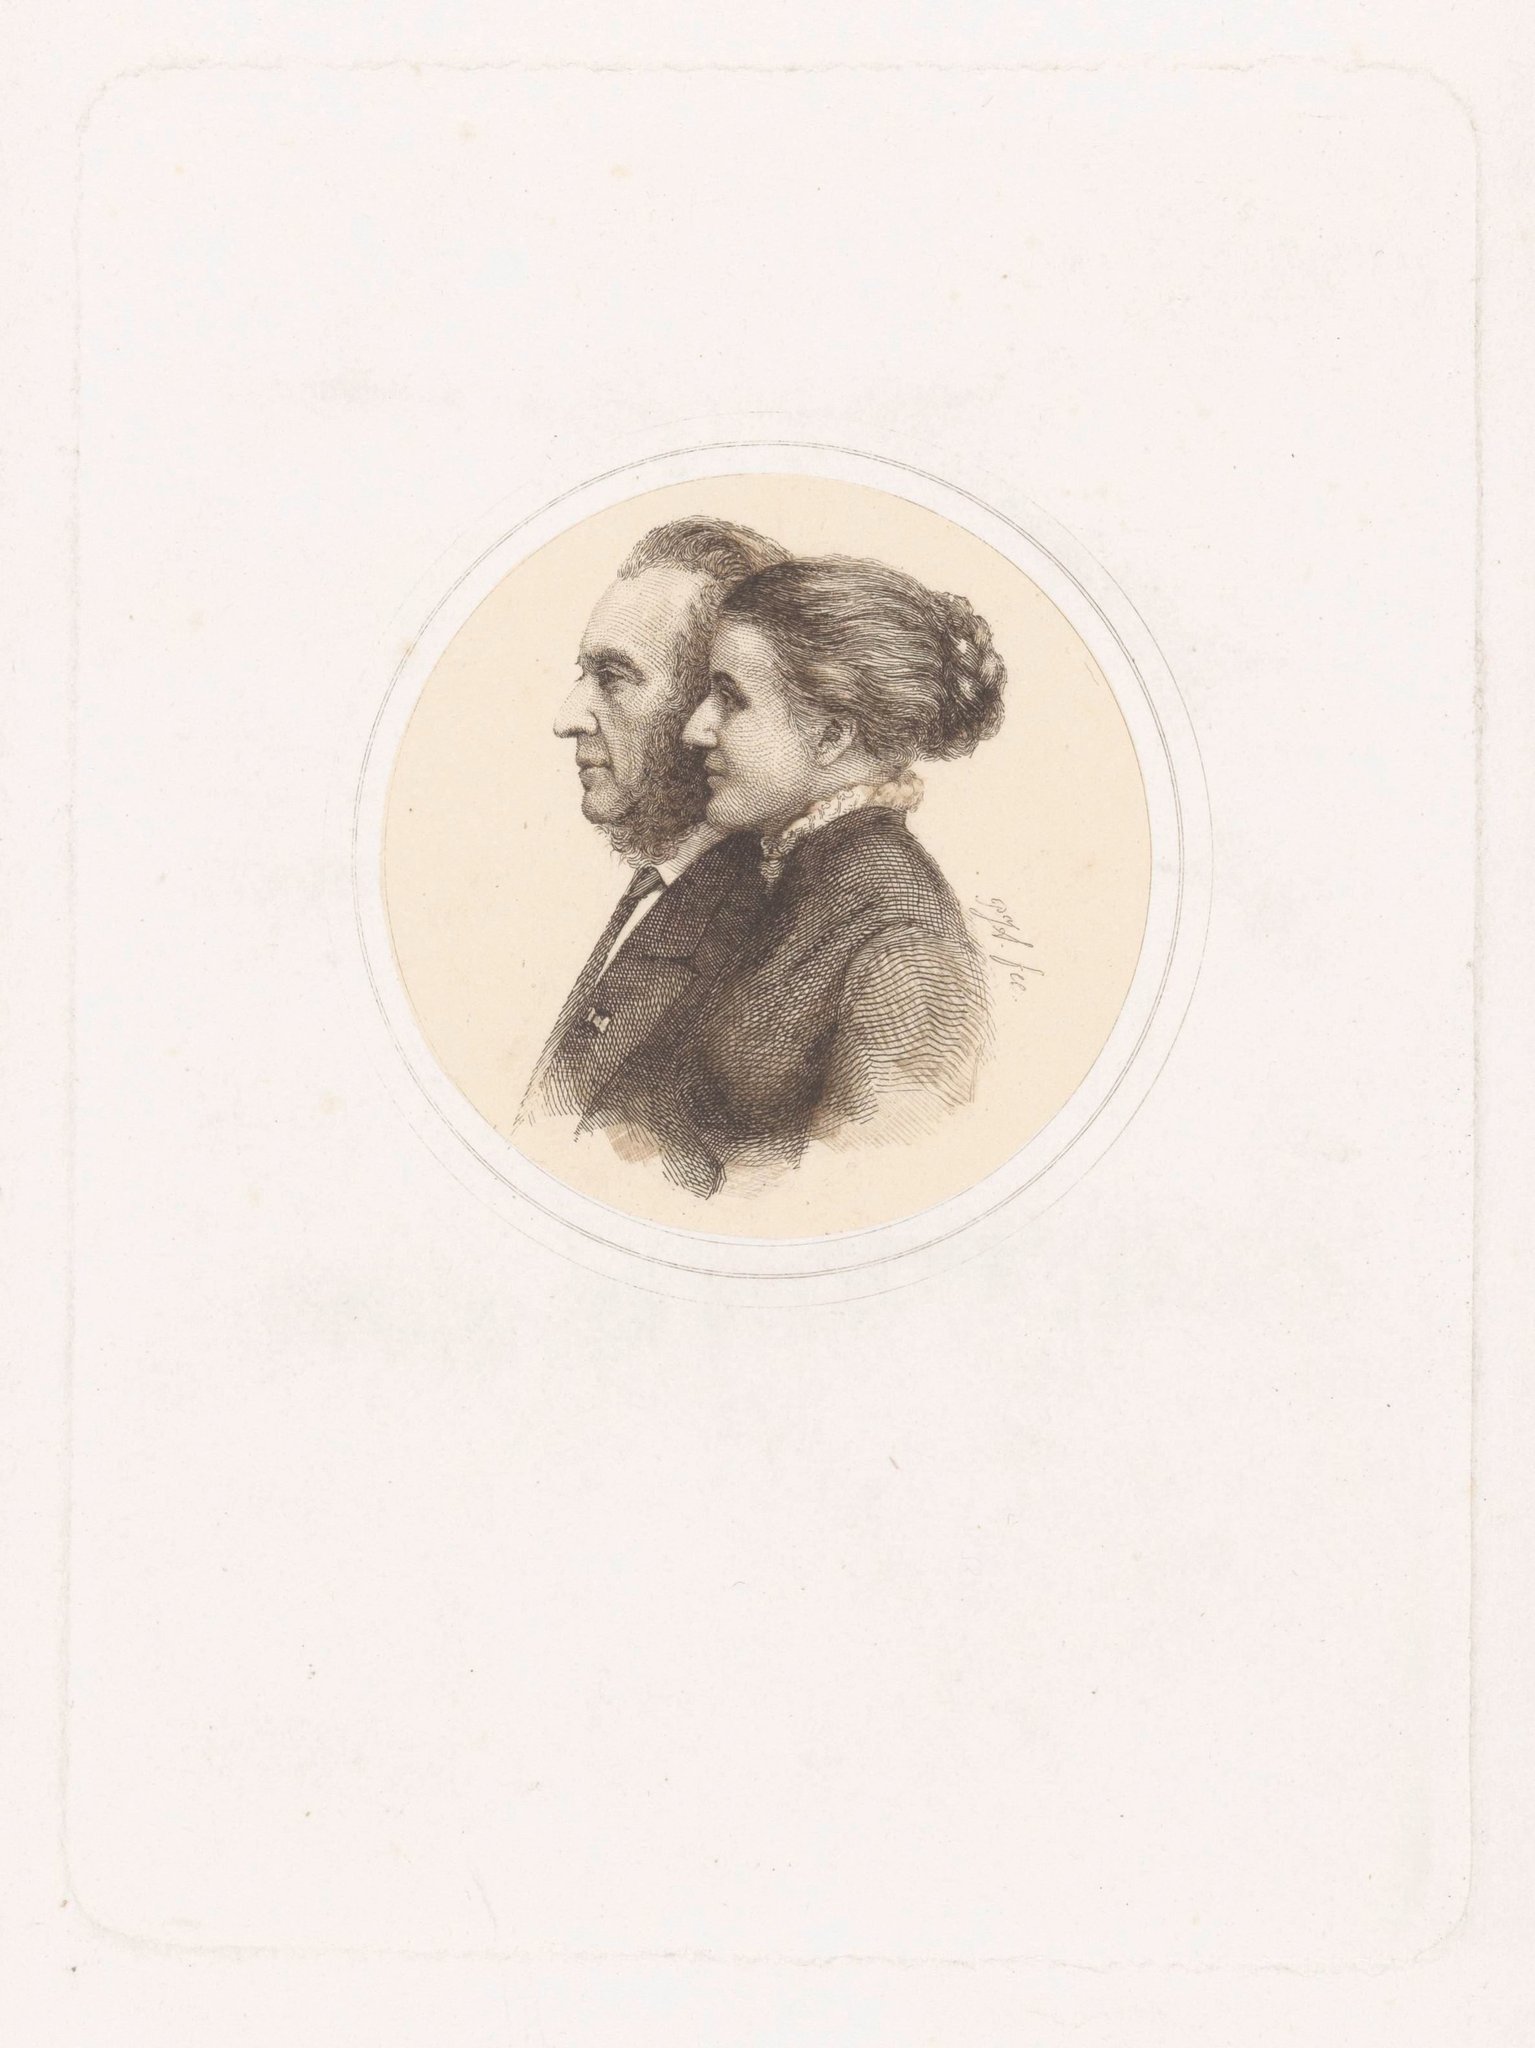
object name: print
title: Portret van Josephus Albertus en Catharina Alberdingk Thijm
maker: petrus johannes arendzen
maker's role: draughtsman, print maker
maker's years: 1846-1932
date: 1870-1906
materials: paper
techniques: engraving, roulette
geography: amsterdam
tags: amsterdam, catharina alberdingk thijm, painter, draughtsman, publisher, josephus albertus alberdingk thijm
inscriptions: collector's mark: Lugt 2228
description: Portret van Josephus Albertus en Catharina Alberdingk Thijm in een cirkelvormige omlijsting.